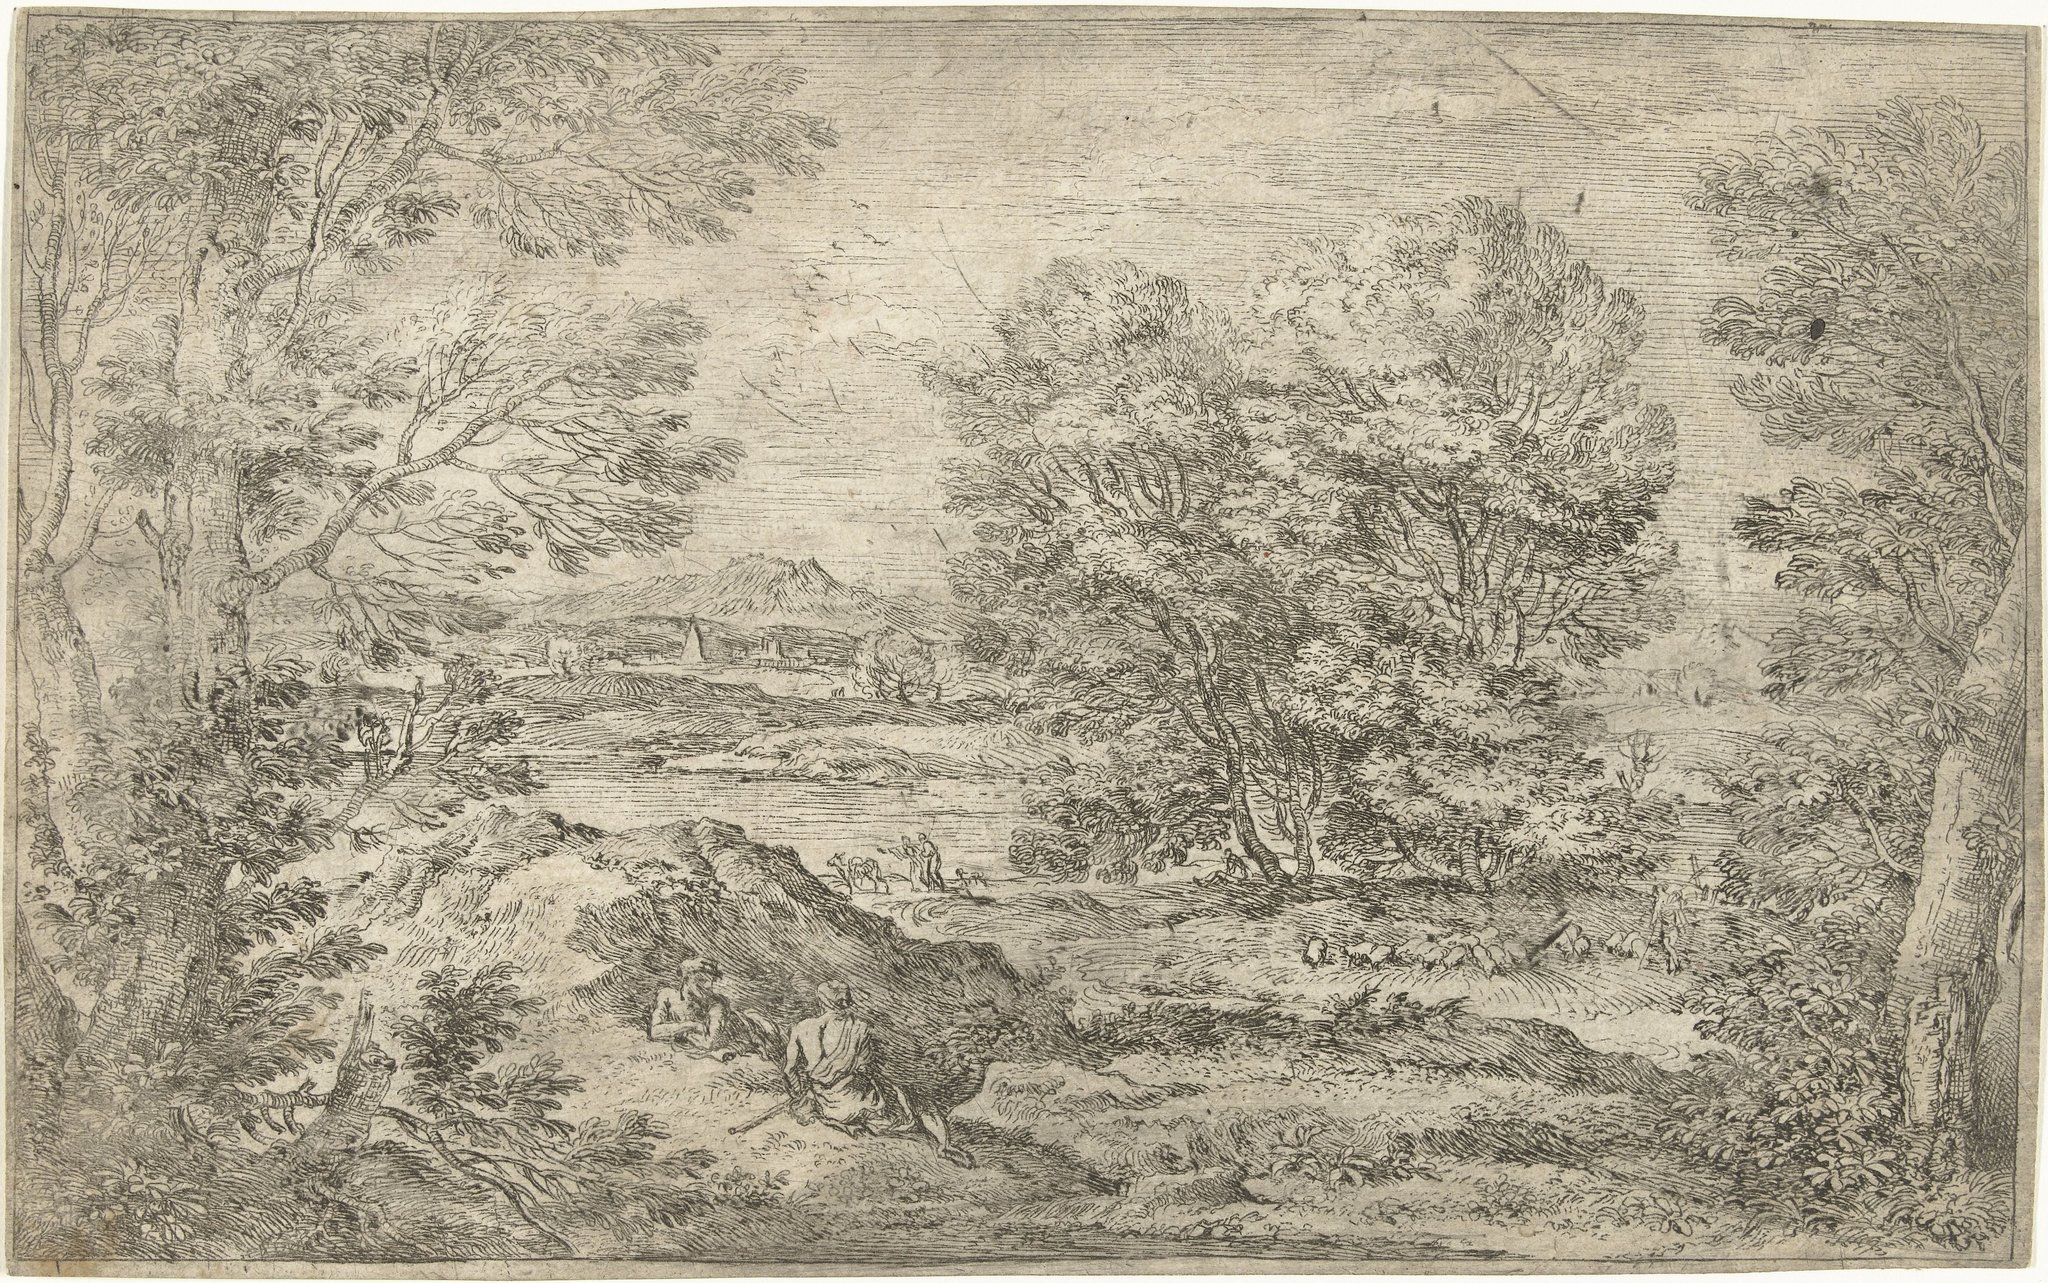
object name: print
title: Landschap met twee personen tegenover elkaar zittend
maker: adriaen van der kabel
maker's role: draughtsman, painter, print maker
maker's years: 1630-1705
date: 1648-1705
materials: paper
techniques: etching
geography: france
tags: landscapes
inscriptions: collector's mark: Lugt 2228, inscription: ‘Sehr seltsame Radirung v. A. v. der Cabel. Ahnlich dem Bl. B. No.18. aber gröfser und ohne Schrift. Eine andere sehr geiftreich radi..., aber .....mifslungere... Platte. Nieder v. Bartsch, noch von Weigel beschrieben. J.A. Boerner NJ. mh (?)’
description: Landschap met op de voorgrond twee personen, waarvan één op de rug gezien, tegenover elkaar zittend bij een meertje. Op de achtergrond twee personen met hond en ezel, lopend langs een rivier. Afgekeurde plaat voor de vijfde prent uit de prent serie "Landschappen, serie twee".